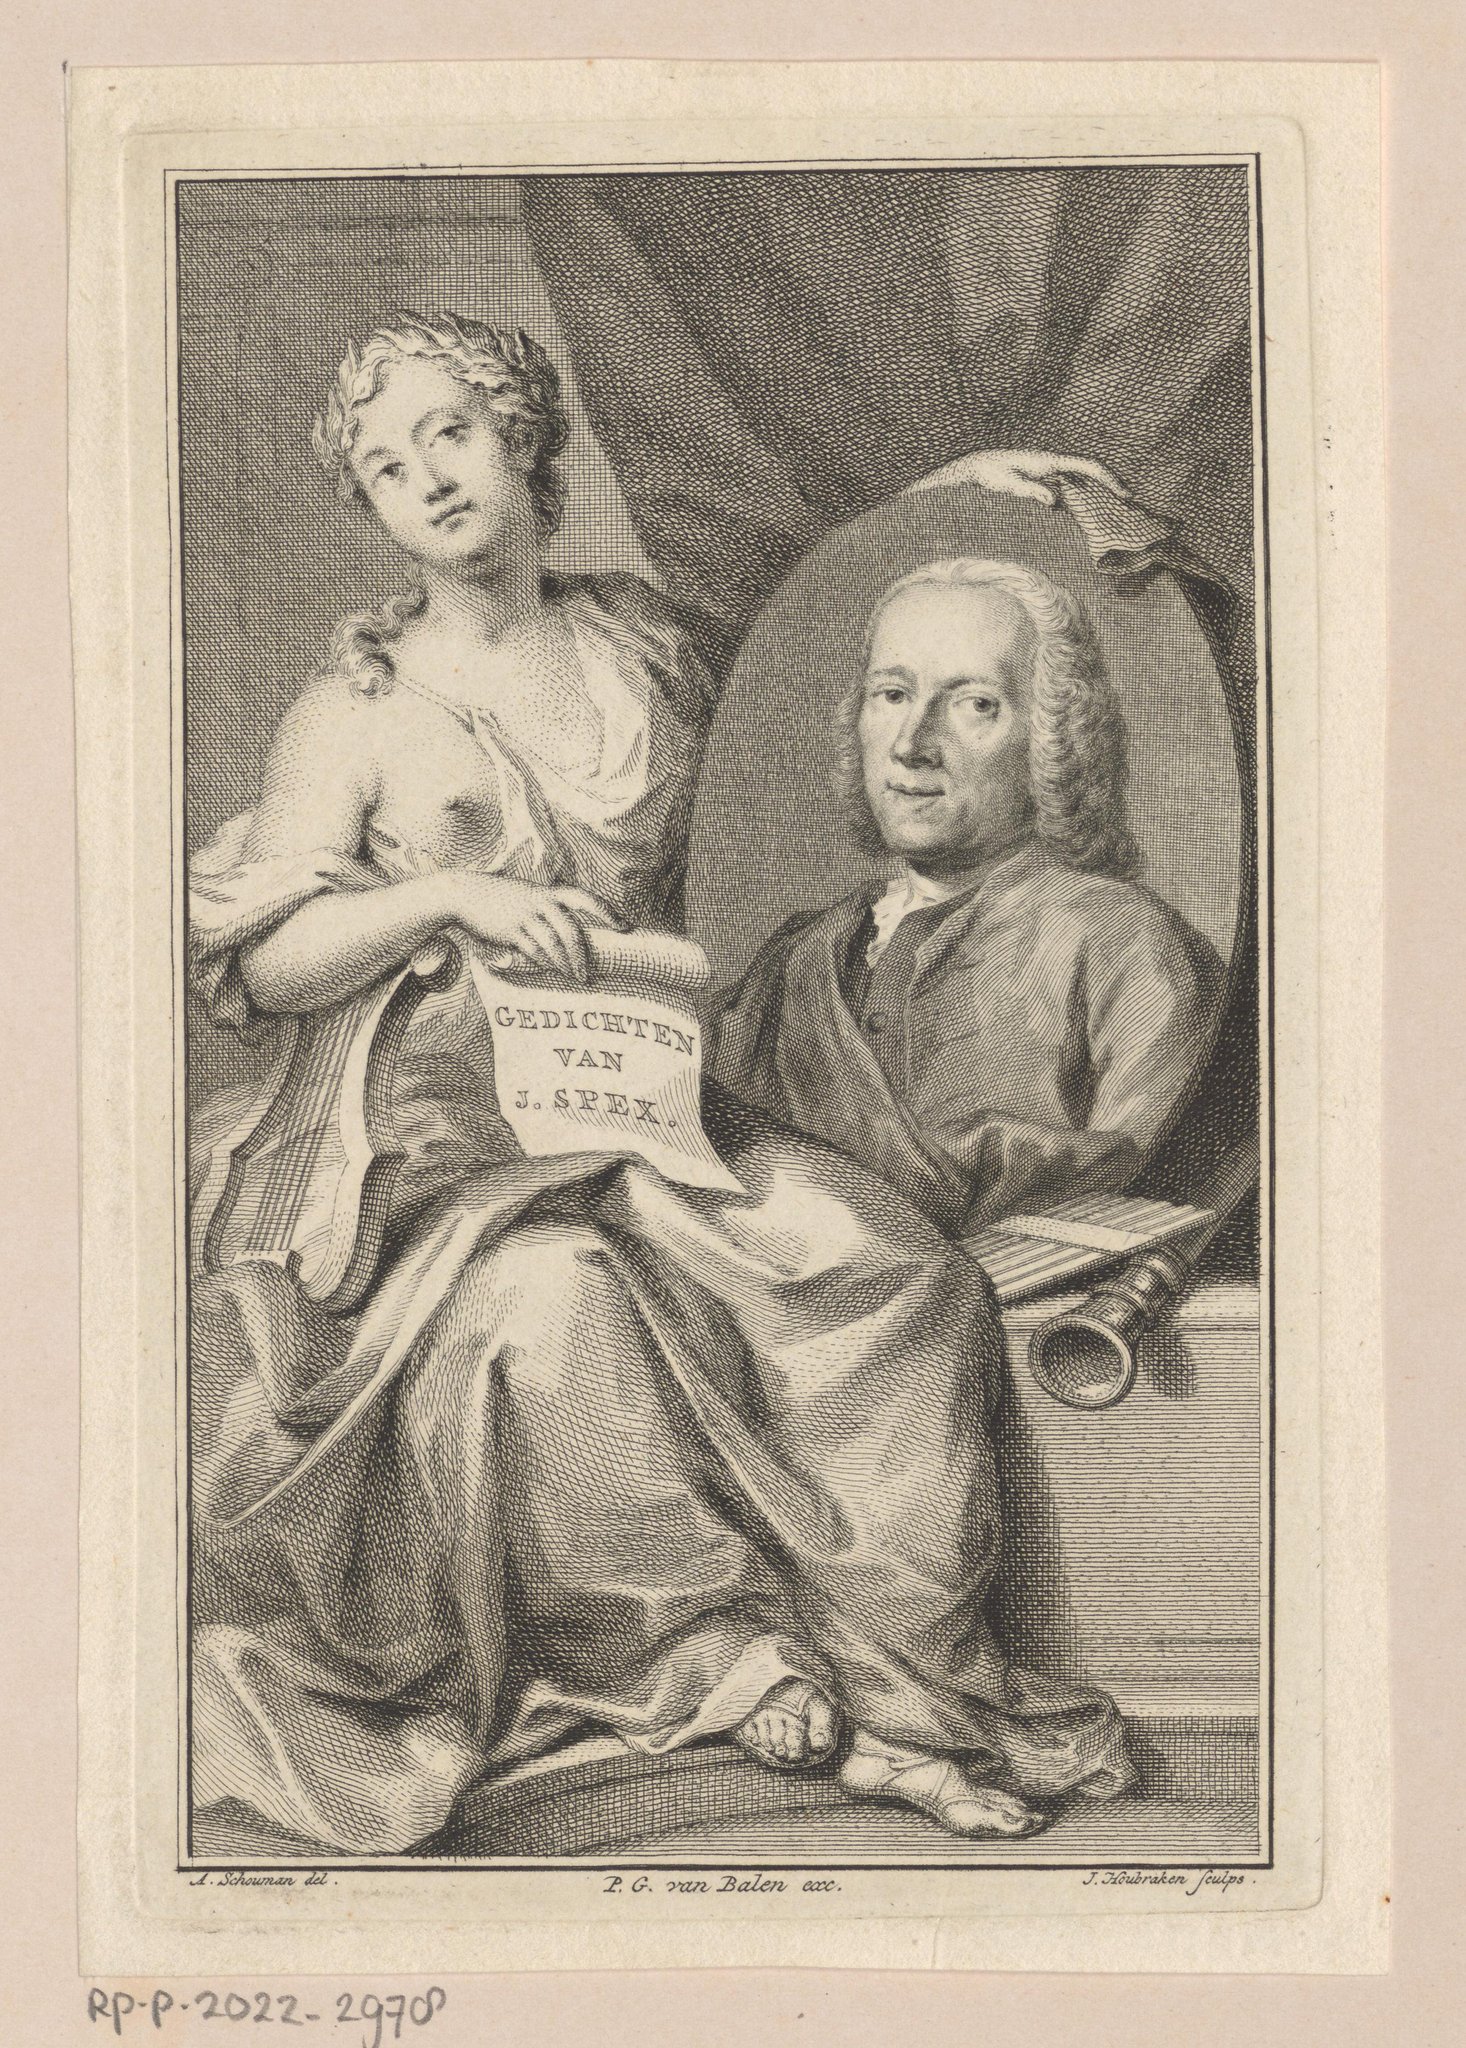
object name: print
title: Portret van Jacob Spex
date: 1755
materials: paper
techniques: engraving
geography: the hague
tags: jacob spex, historical persons, writer, poet, author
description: Prent waarschijnlijk uit: Spex, Jacob. Gedichten van Jakob Spex. Den Haag: Pieter Gerard van Balen, 1755.